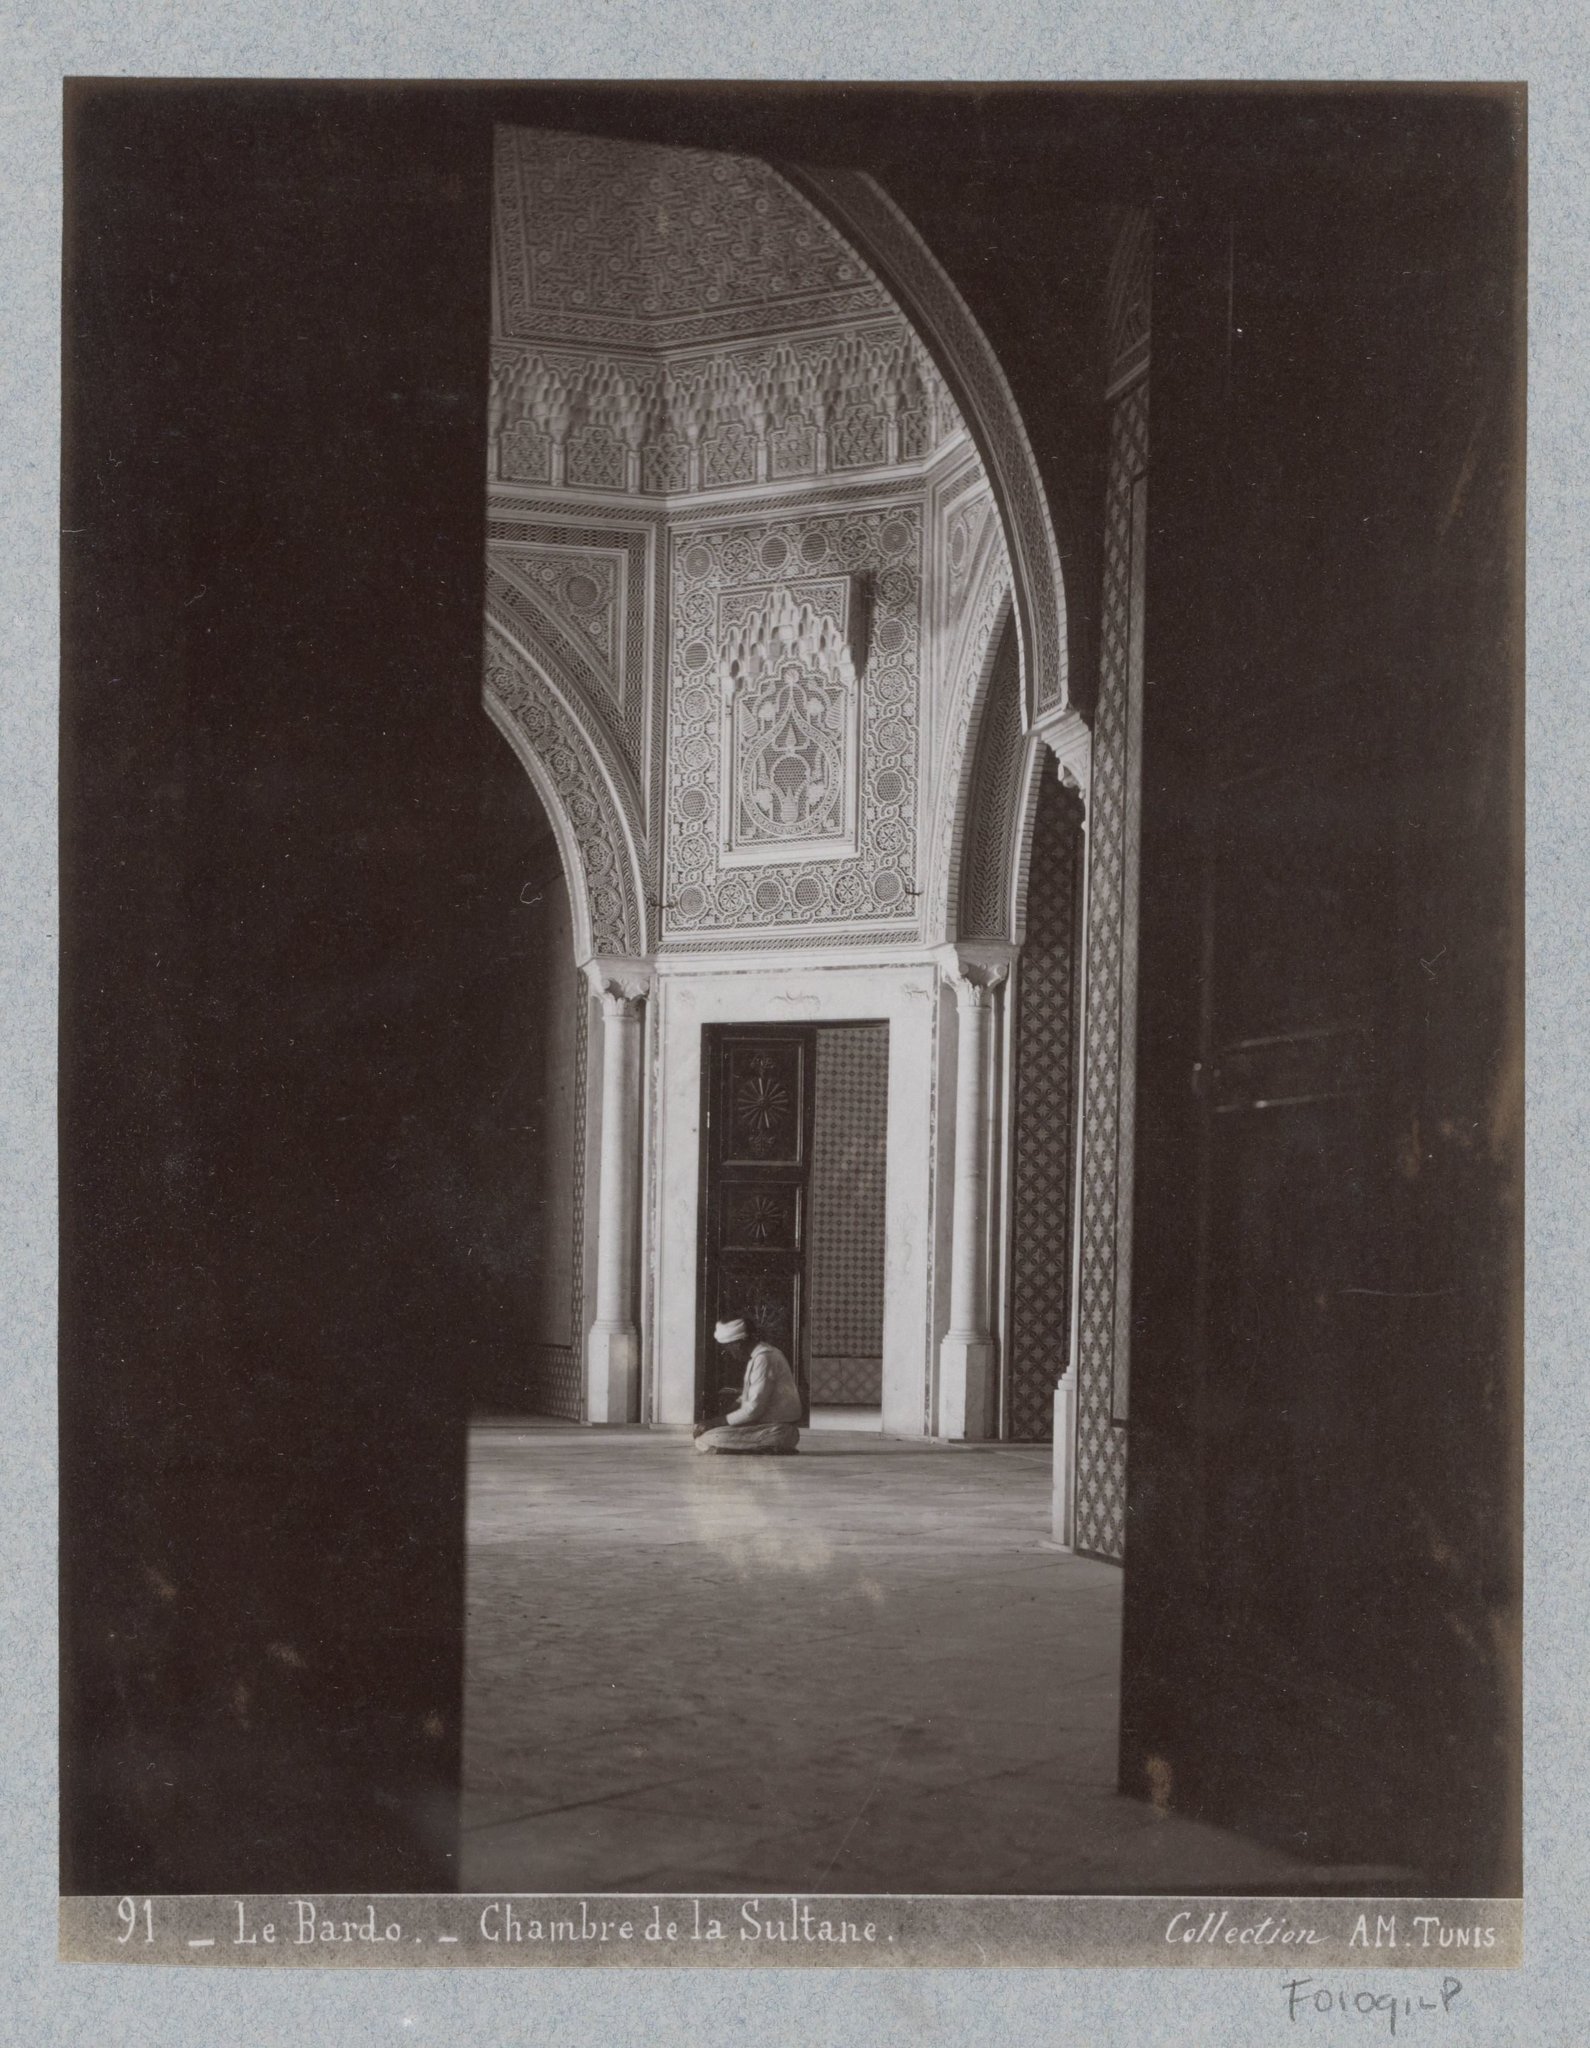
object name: album leaf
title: Doorkijk naar de kamer van de sultan in het Bardopaleis in Tunis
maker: am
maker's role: fotograaf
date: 1880-1900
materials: paper, photographic support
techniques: albumen print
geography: tunis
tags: palace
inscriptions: negative number: ‘91’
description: Onderdeel van Reisalbum met foto's van bezienswaardigheden in Tunis en Tunesië.